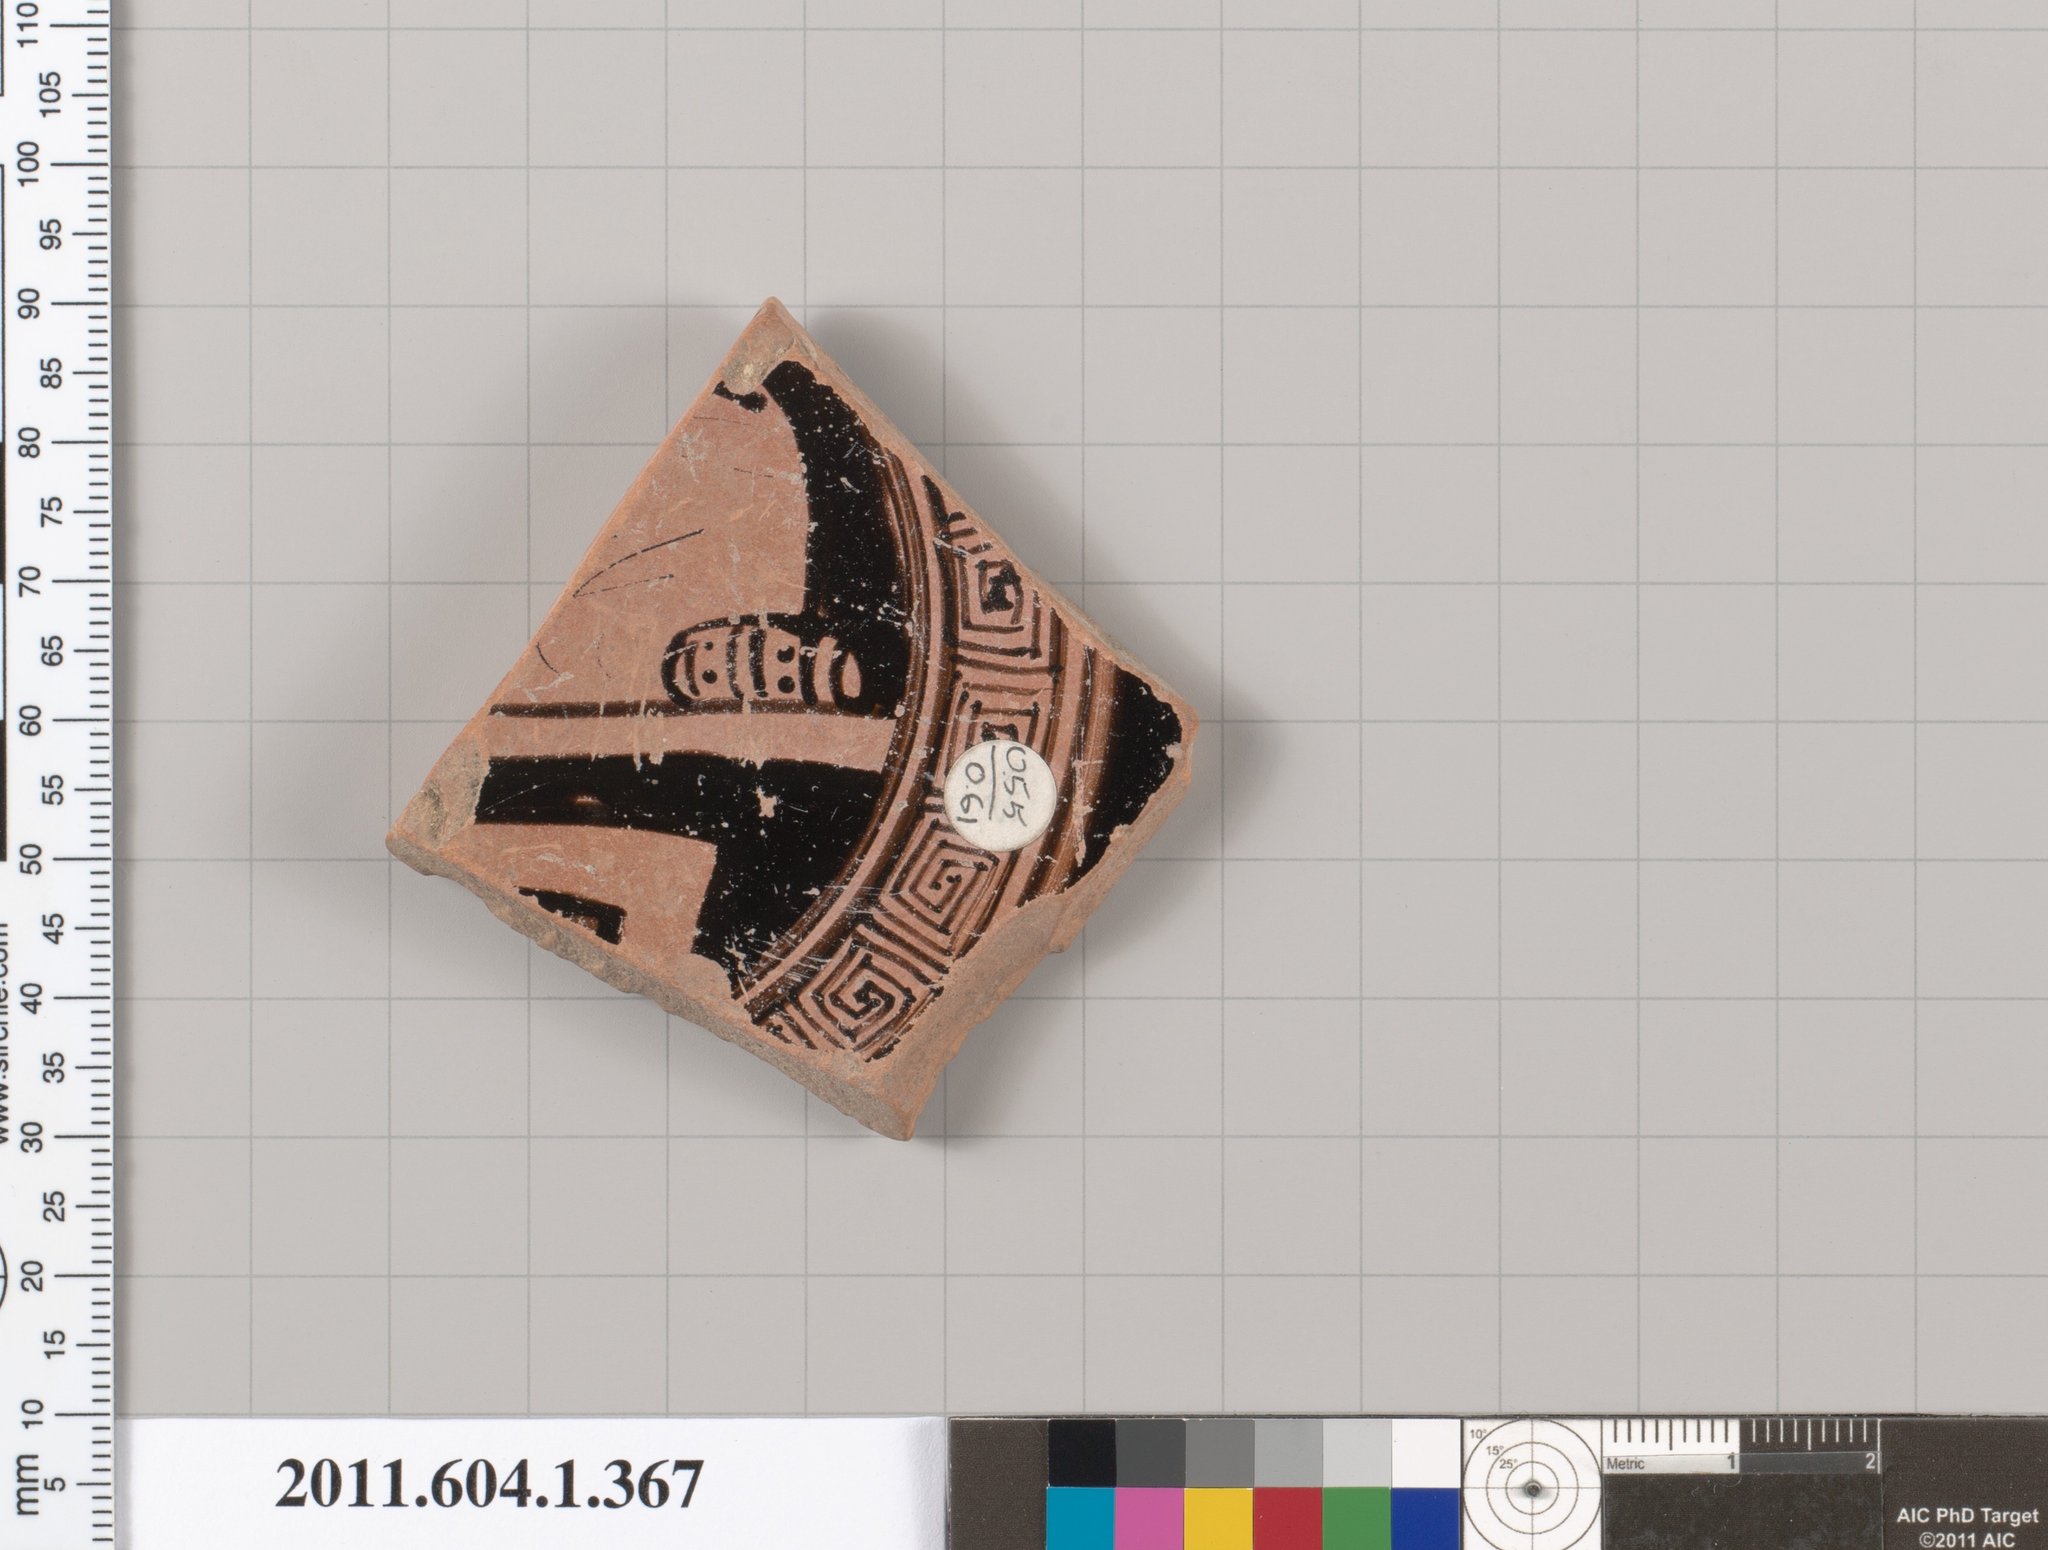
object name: kylix fragment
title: Terracotta fragment of a kylix (drinking cup)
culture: greek, attic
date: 467-435 BCE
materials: terracotta